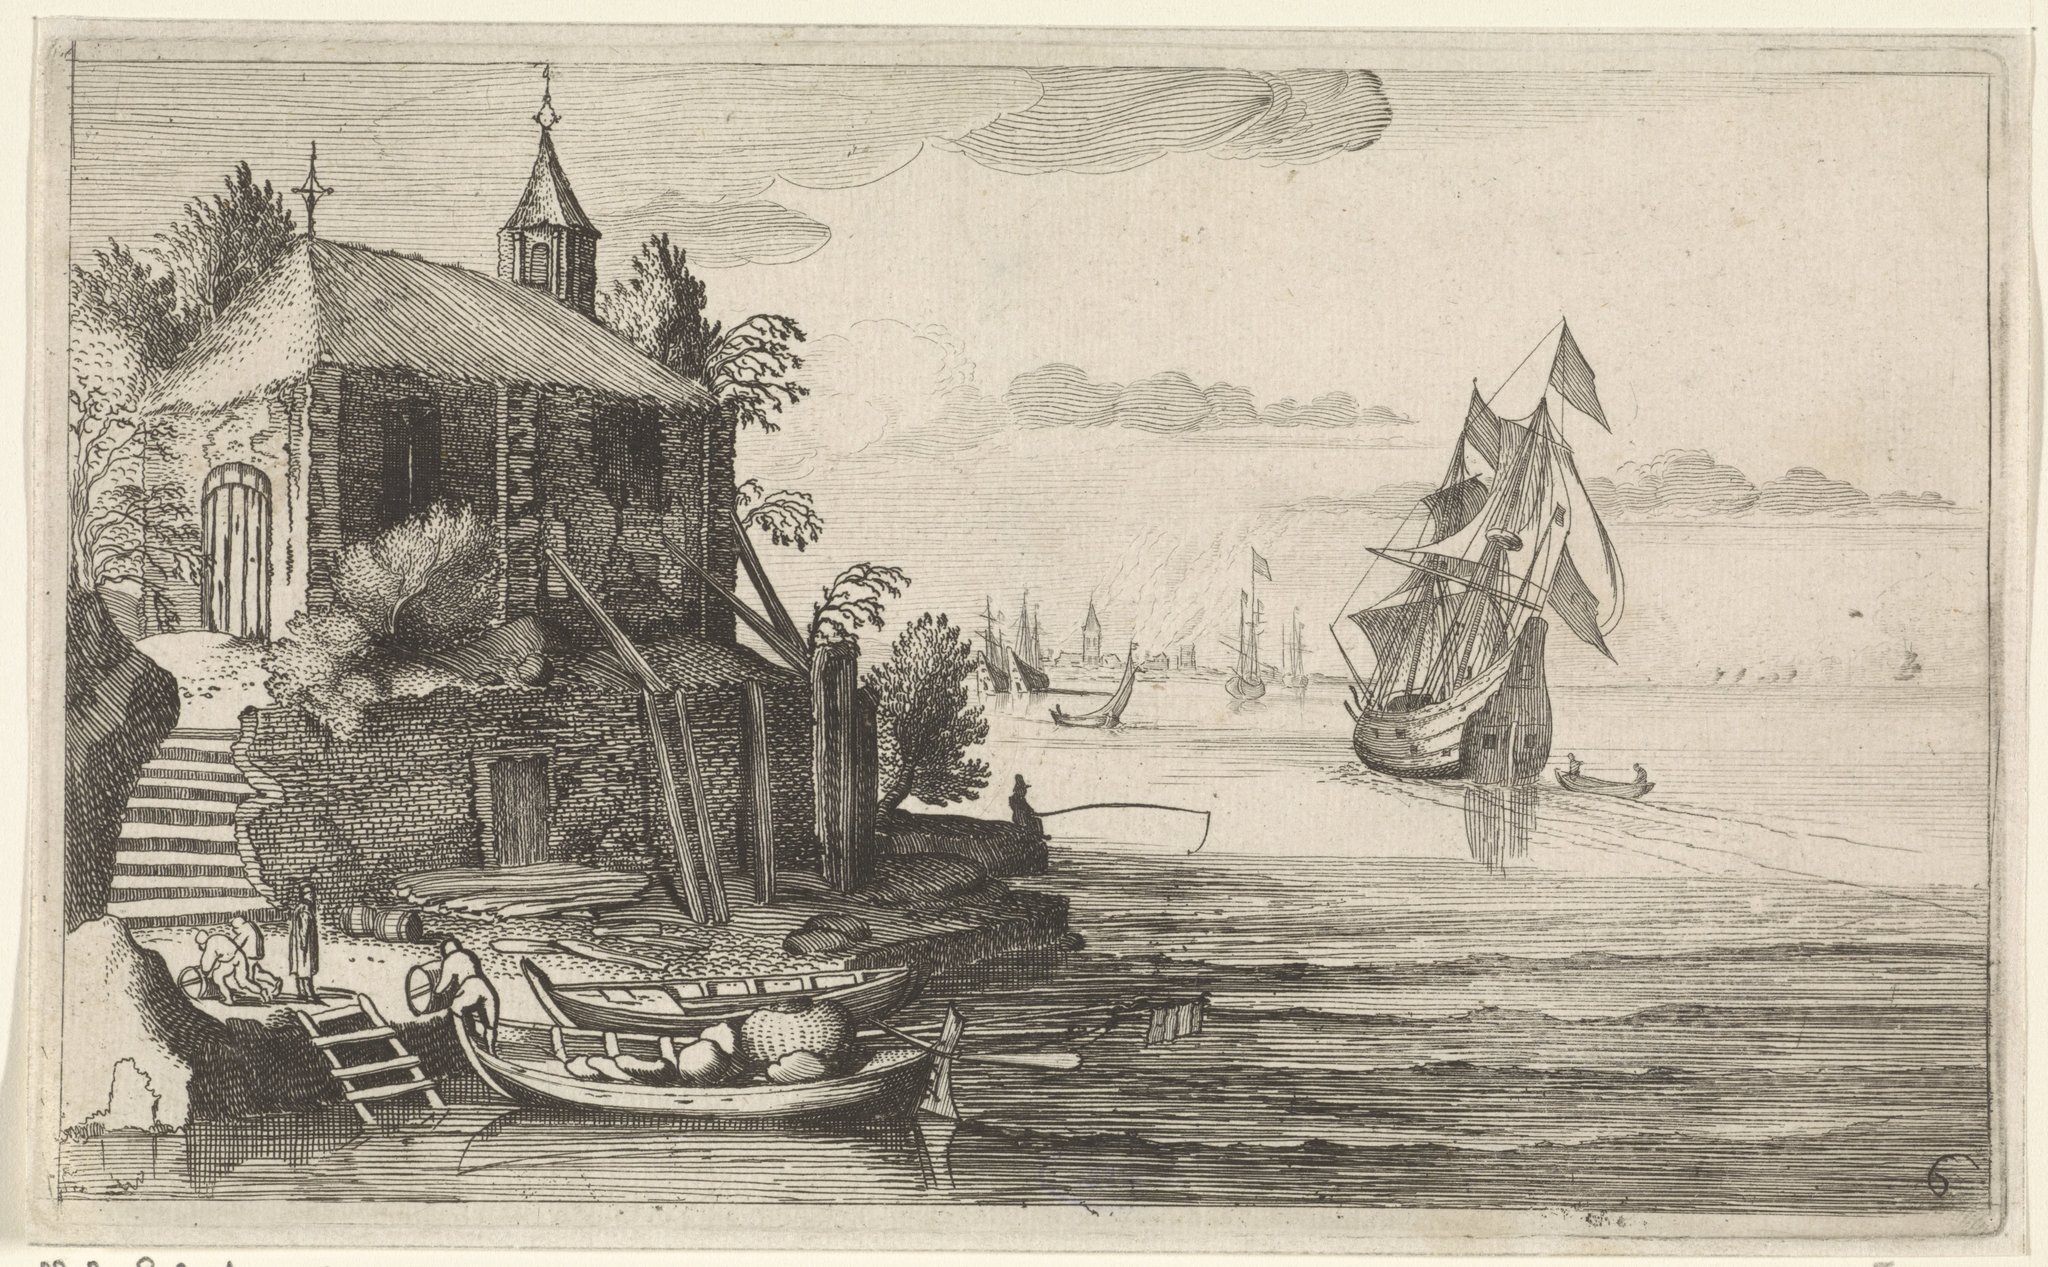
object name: print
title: Tweemaster bij een kust met een kapel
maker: jan van de velde (ii)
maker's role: draughtsman, painter, print maker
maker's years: 1593-1641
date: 1603-1641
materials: paper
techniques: engraving, etching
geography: northern netherlands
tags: sailing-ship, sailing-boat, church (exterior) - qq - small church, chapel, coast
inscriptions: collector's mark: Lugt 2228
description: Een kust met een tweemaster op het water bij een kapel aan de oever. Figuren ontladen een boot. Prent uit een serie van acht met marines.